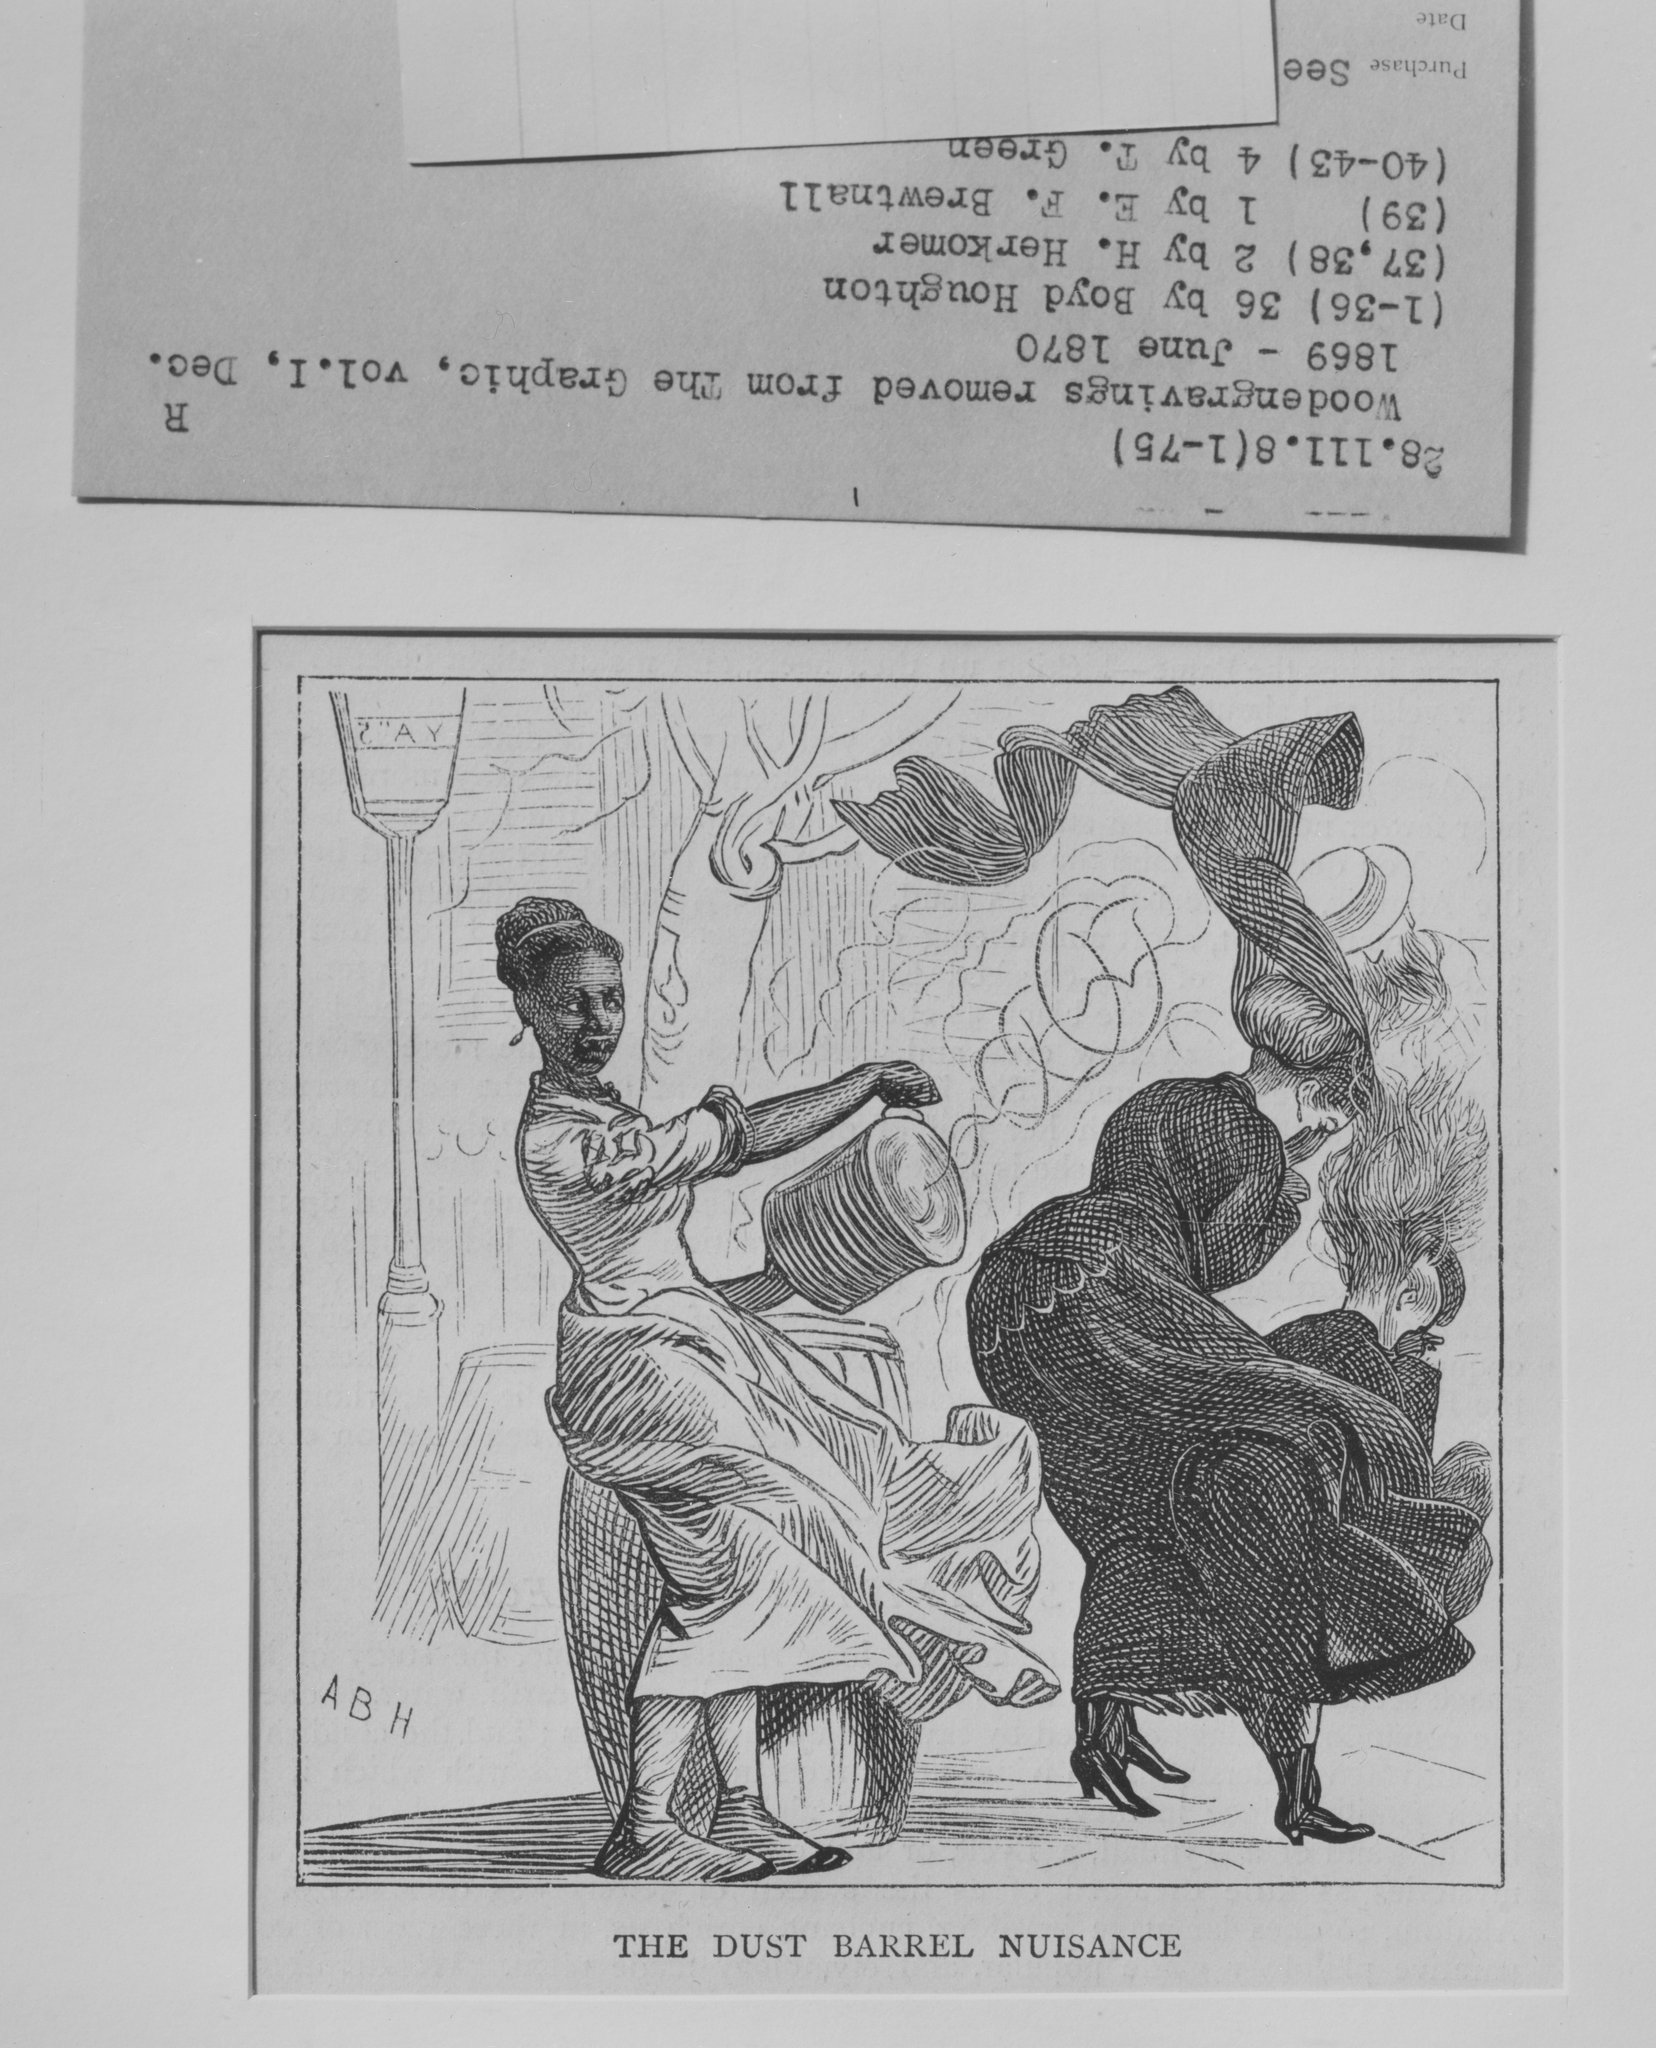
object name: print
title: The Dust Barrel Nuisance, from "The Graphic," vol. 1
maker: arthur boyd houghton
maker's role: artist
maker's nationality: british, born india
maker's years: 1836-1875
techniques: engraving